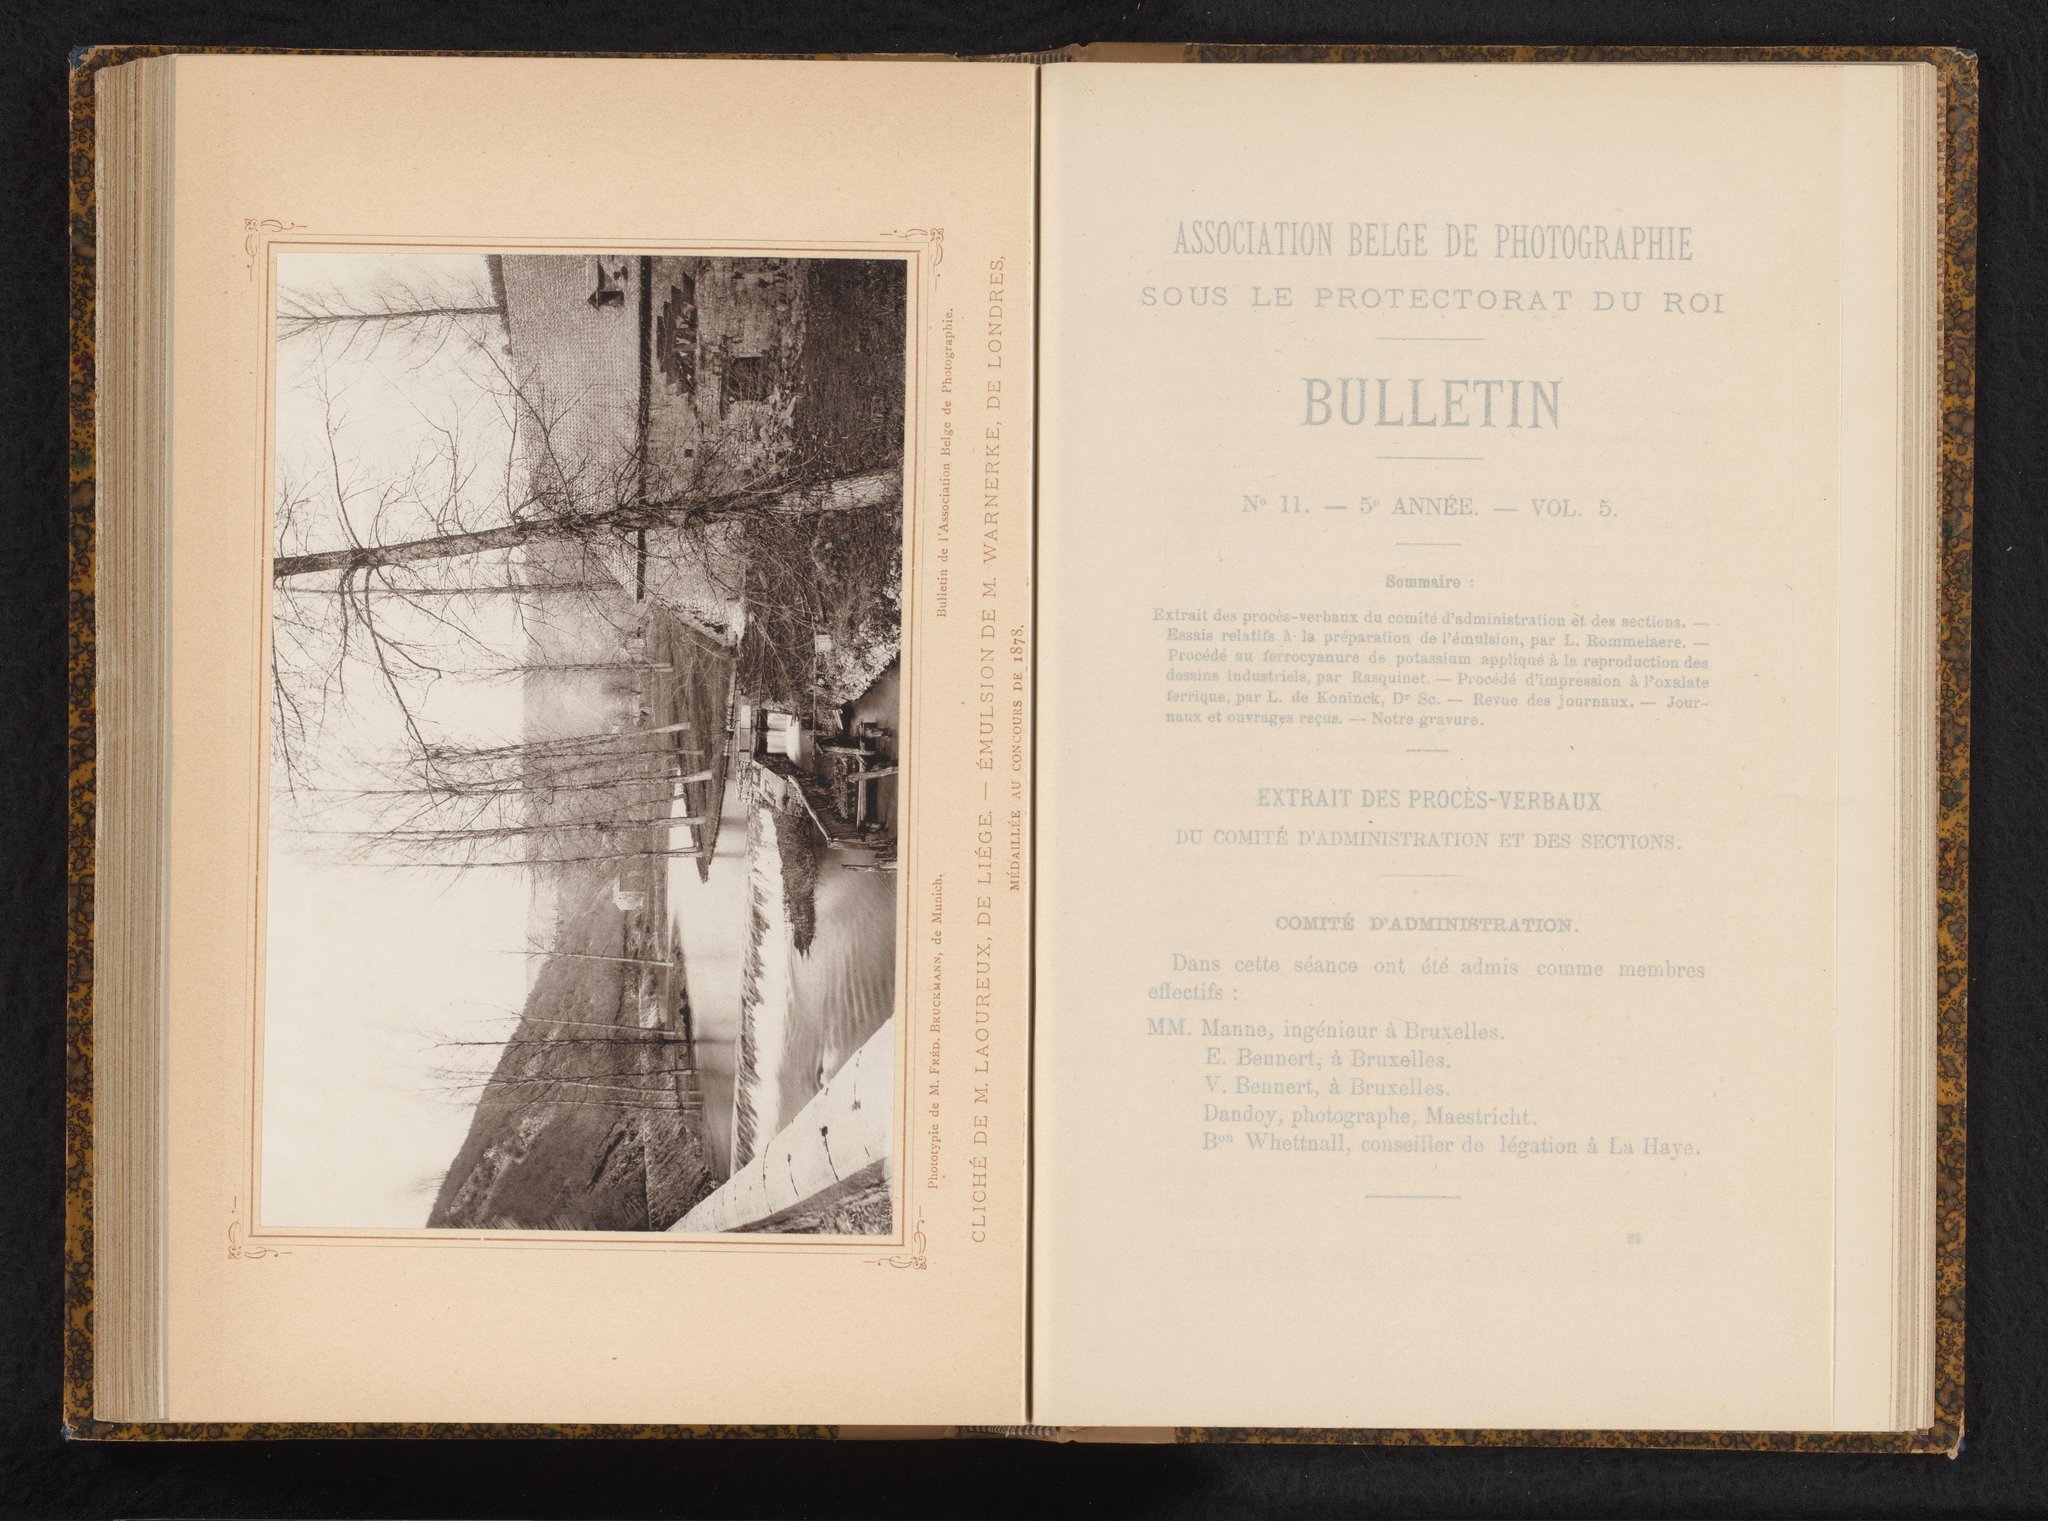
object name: photomechanical print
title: Reproductie van een gravure van een kind met een gitaar in de sneeuw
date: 1878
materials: paper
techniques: photograph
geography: vienna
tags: boy (child between toddler and youth), snow, cithern, mandolin, guitar, balalaika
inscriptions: inscription: ‘Phototypie’